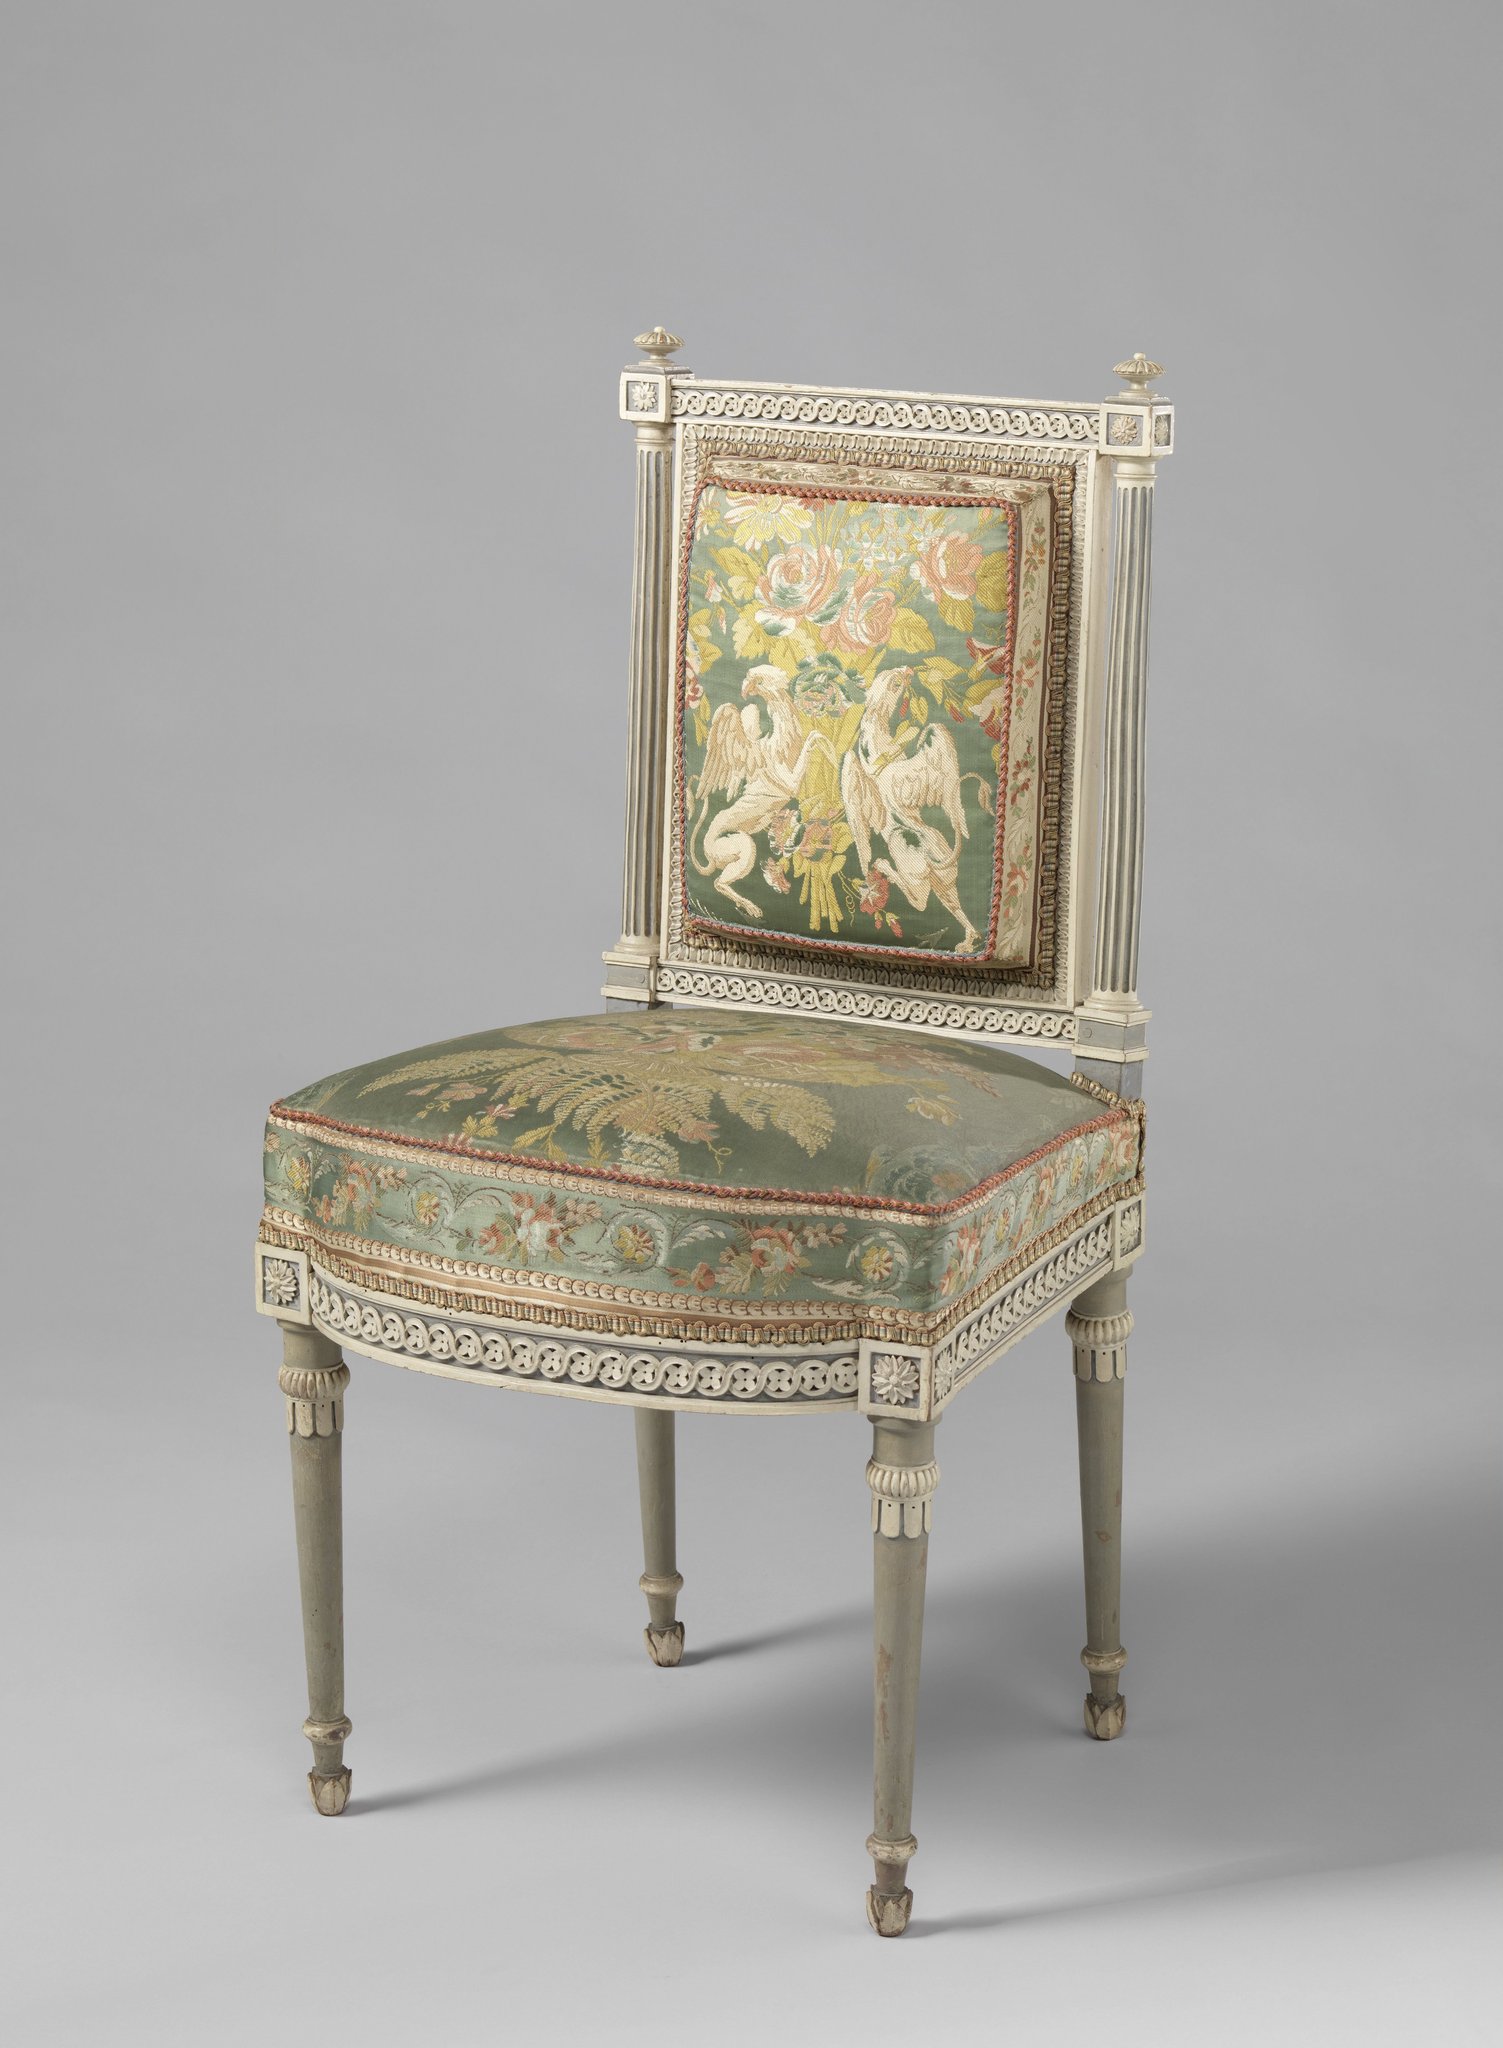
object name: chair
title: Stoel Kops-ameublement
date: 1793-1795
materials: wood, paint, silk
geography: amsterdam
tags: griffin (lion/eagle); 'griffo' (ripa), flowers ~ ornament